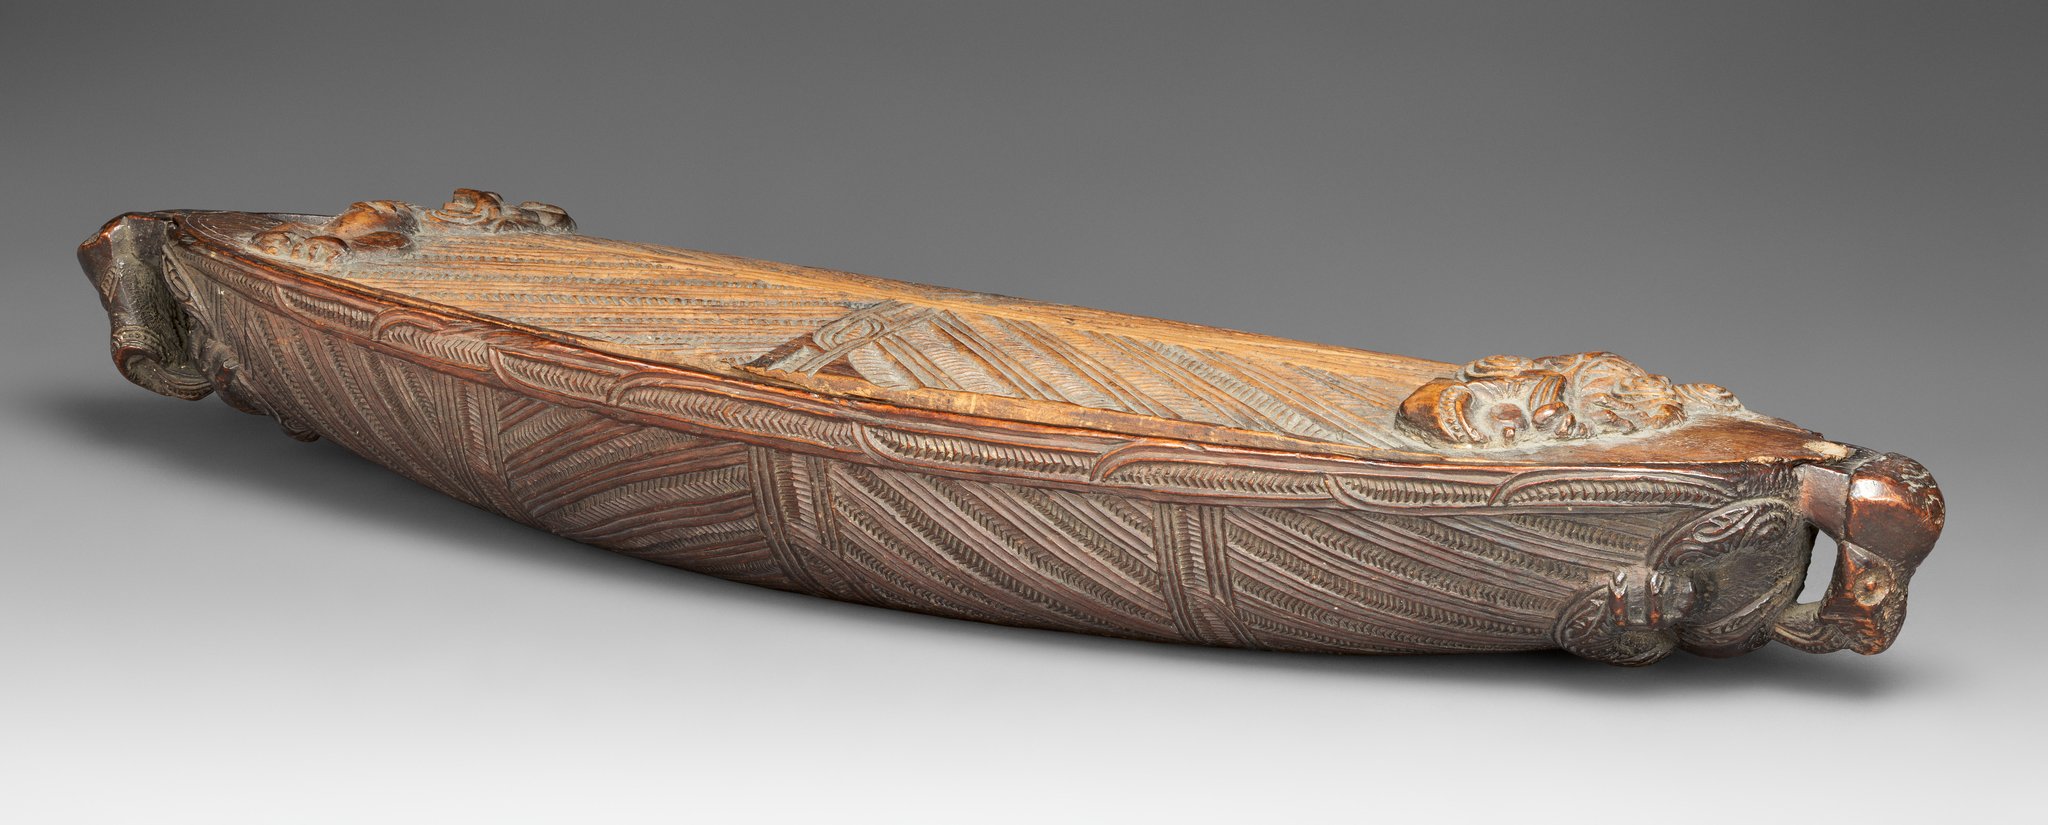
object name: box with lid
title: Treasure Box (Wakahuia)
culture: maori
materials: wood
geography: new zealand